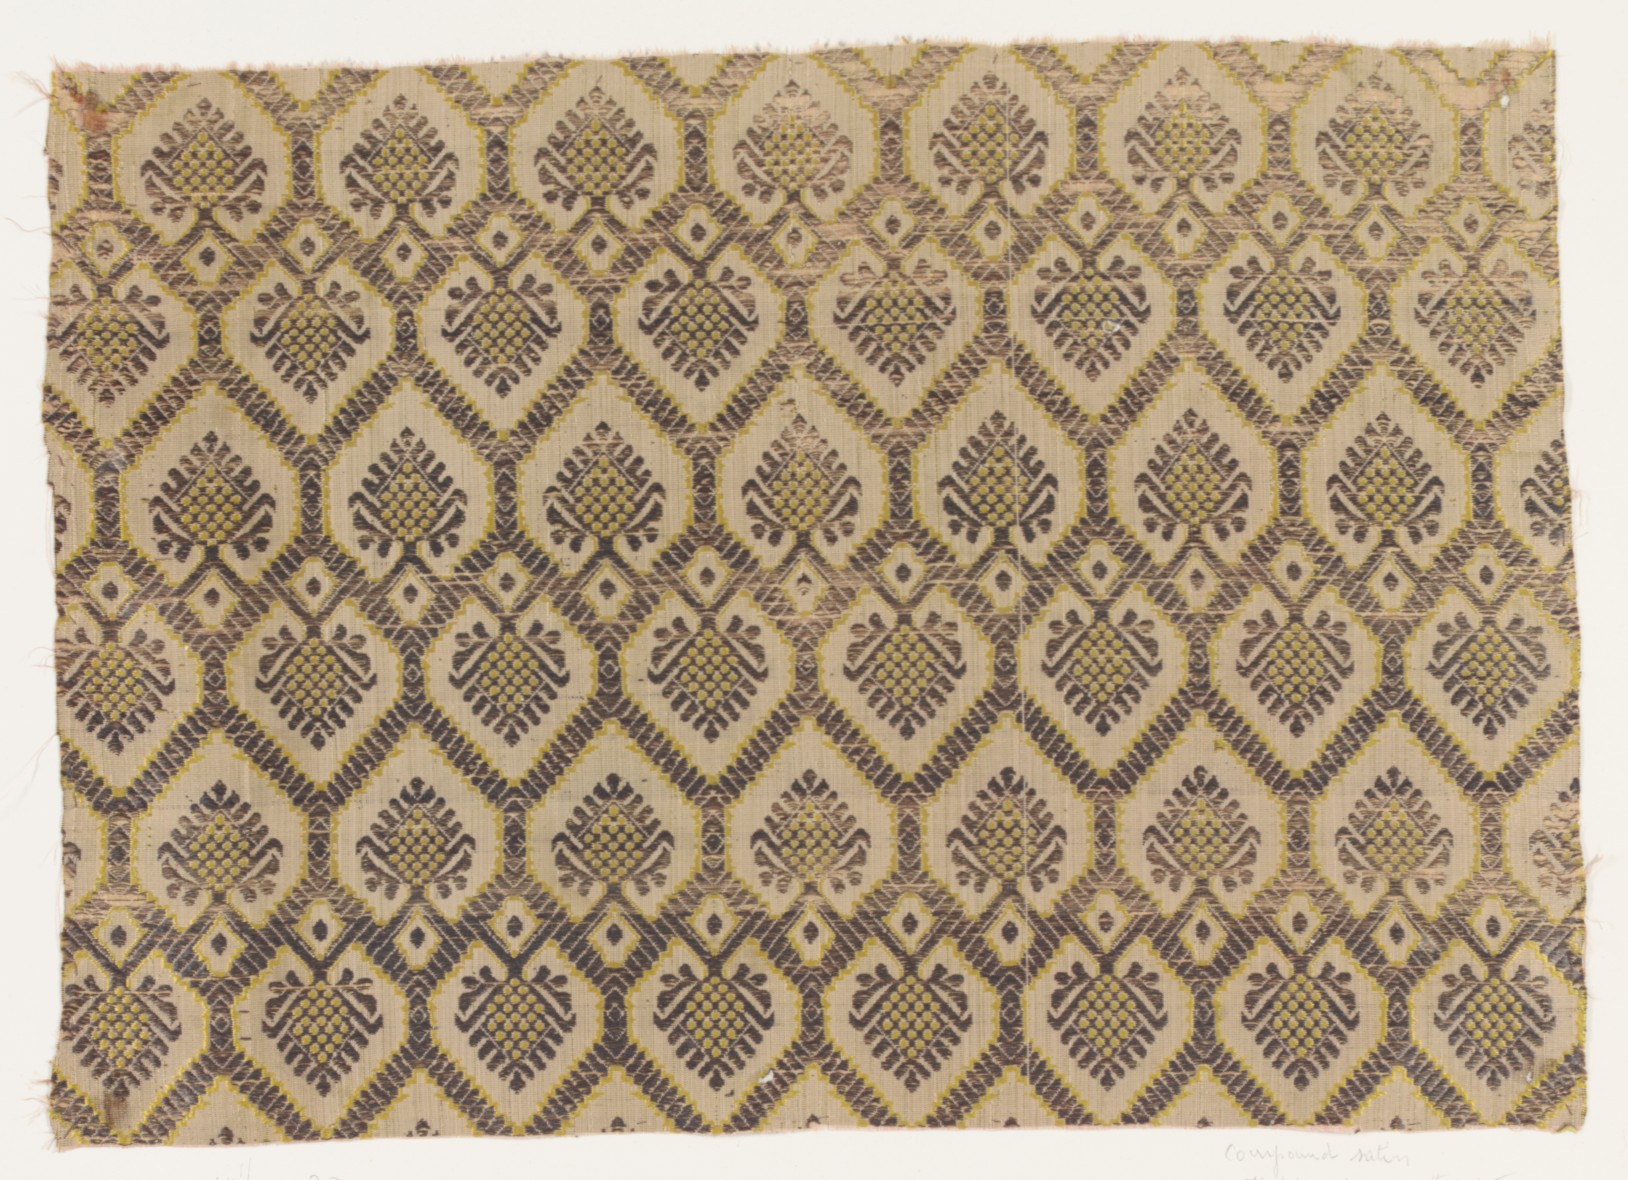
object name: fragment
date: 1567-1600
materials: silk